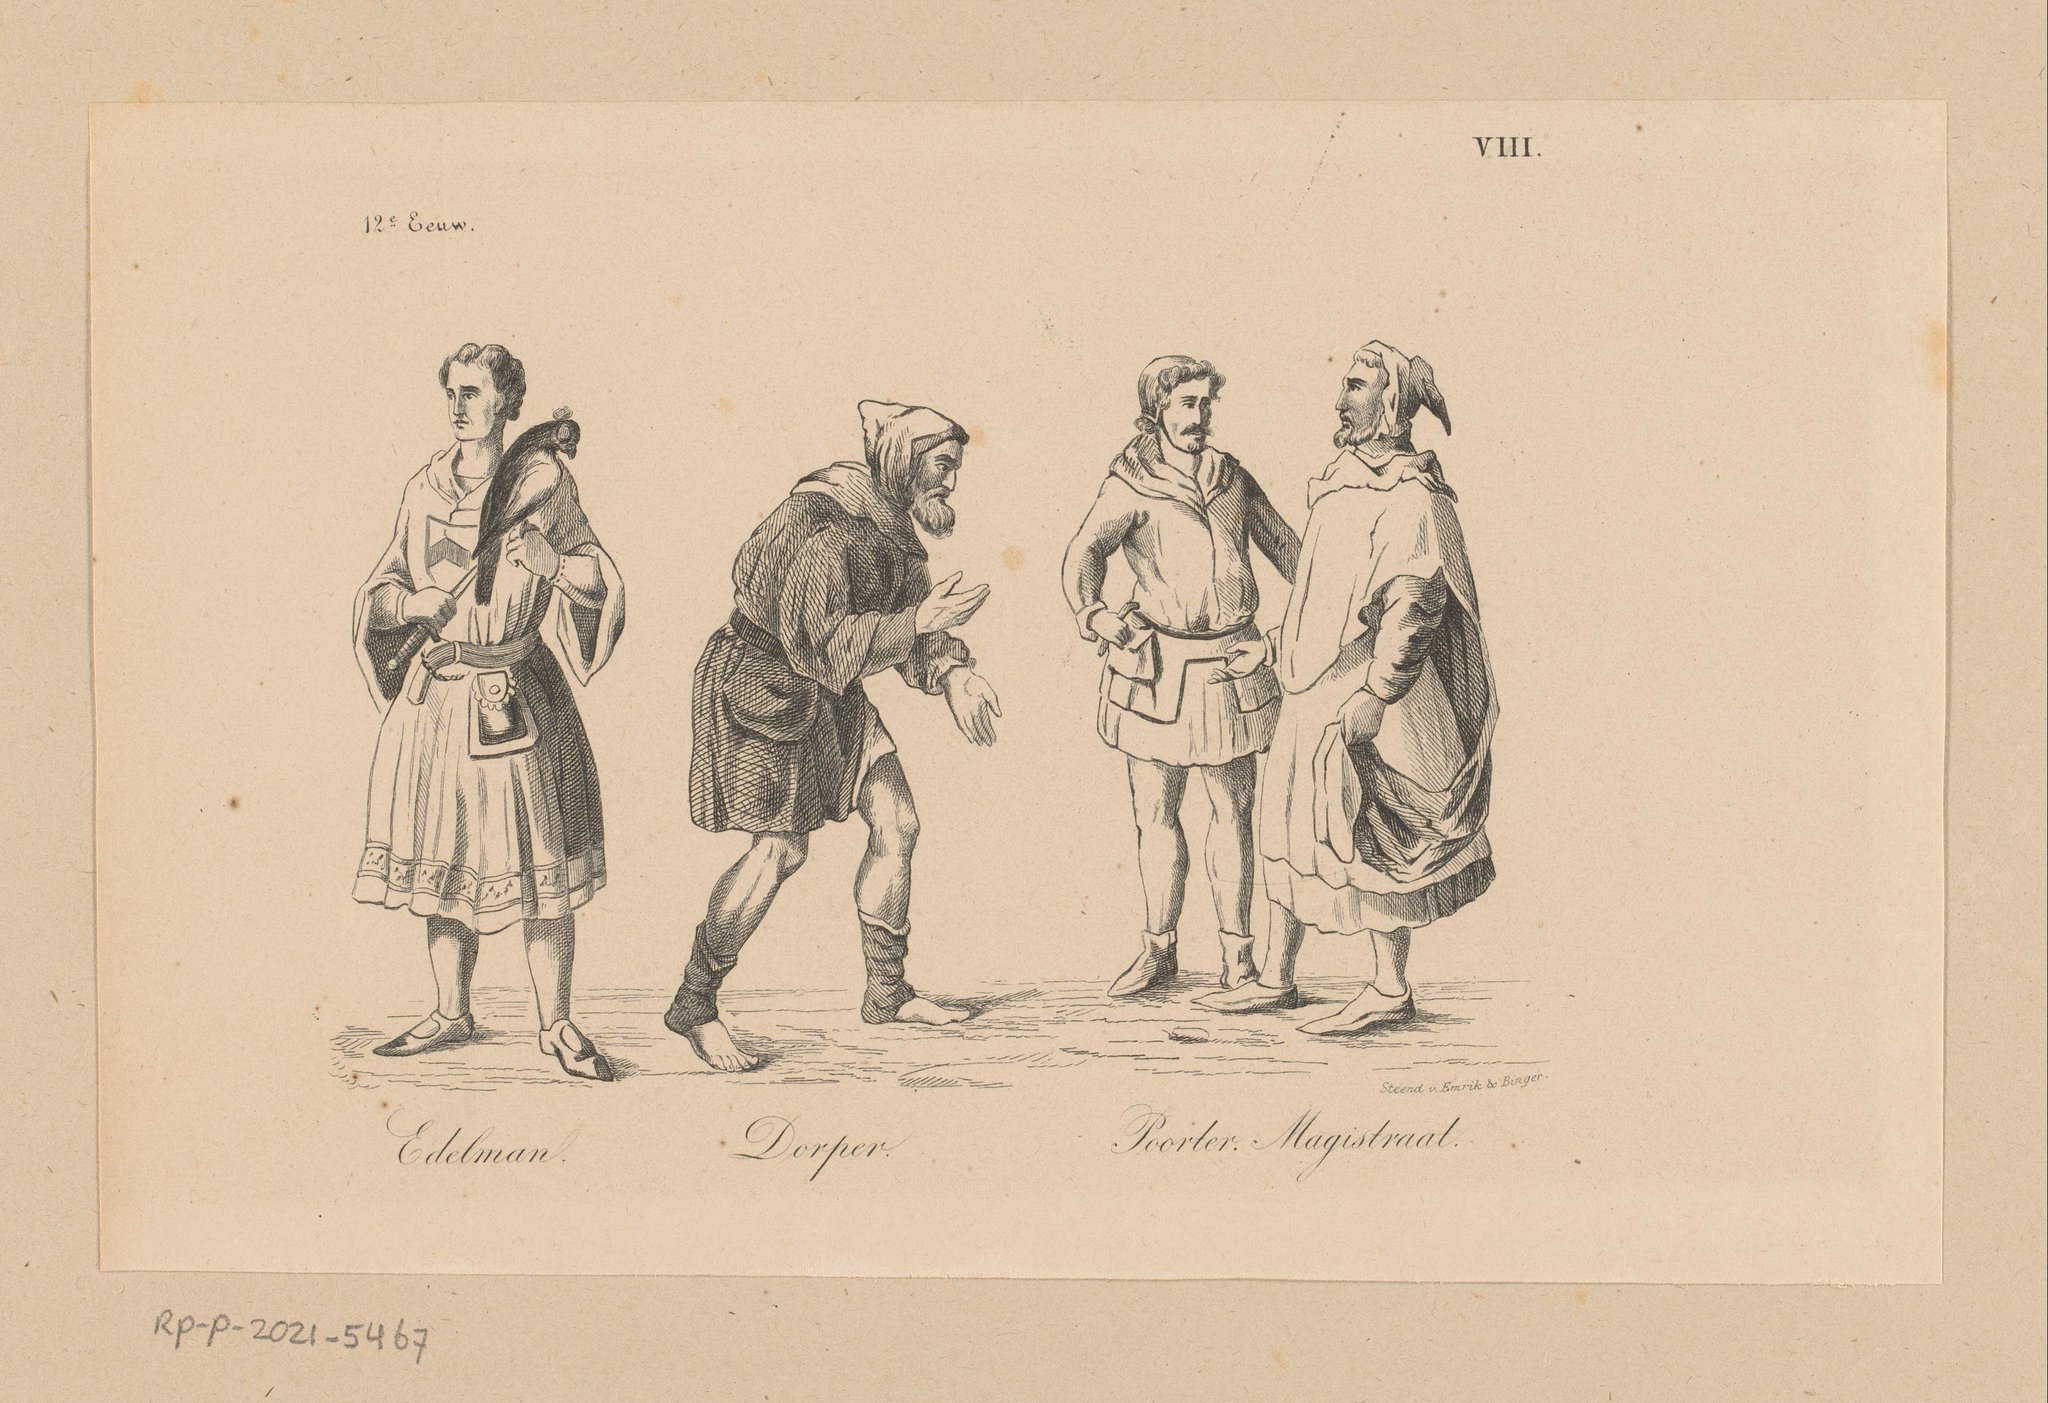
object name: print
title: Edelman, boer, poorter en magistraat in kleding uit de twaalfde eeuw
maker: Anonymous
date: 1857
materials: paper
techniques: lithograph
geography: haarlem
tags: clothes, costume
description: Prent waarschijnlijk uit: Hofdijk, Willem Jacob. Schets van de geschiedenis der Nederlanden. Amsterdam: Gebroeders Binger, 1857.